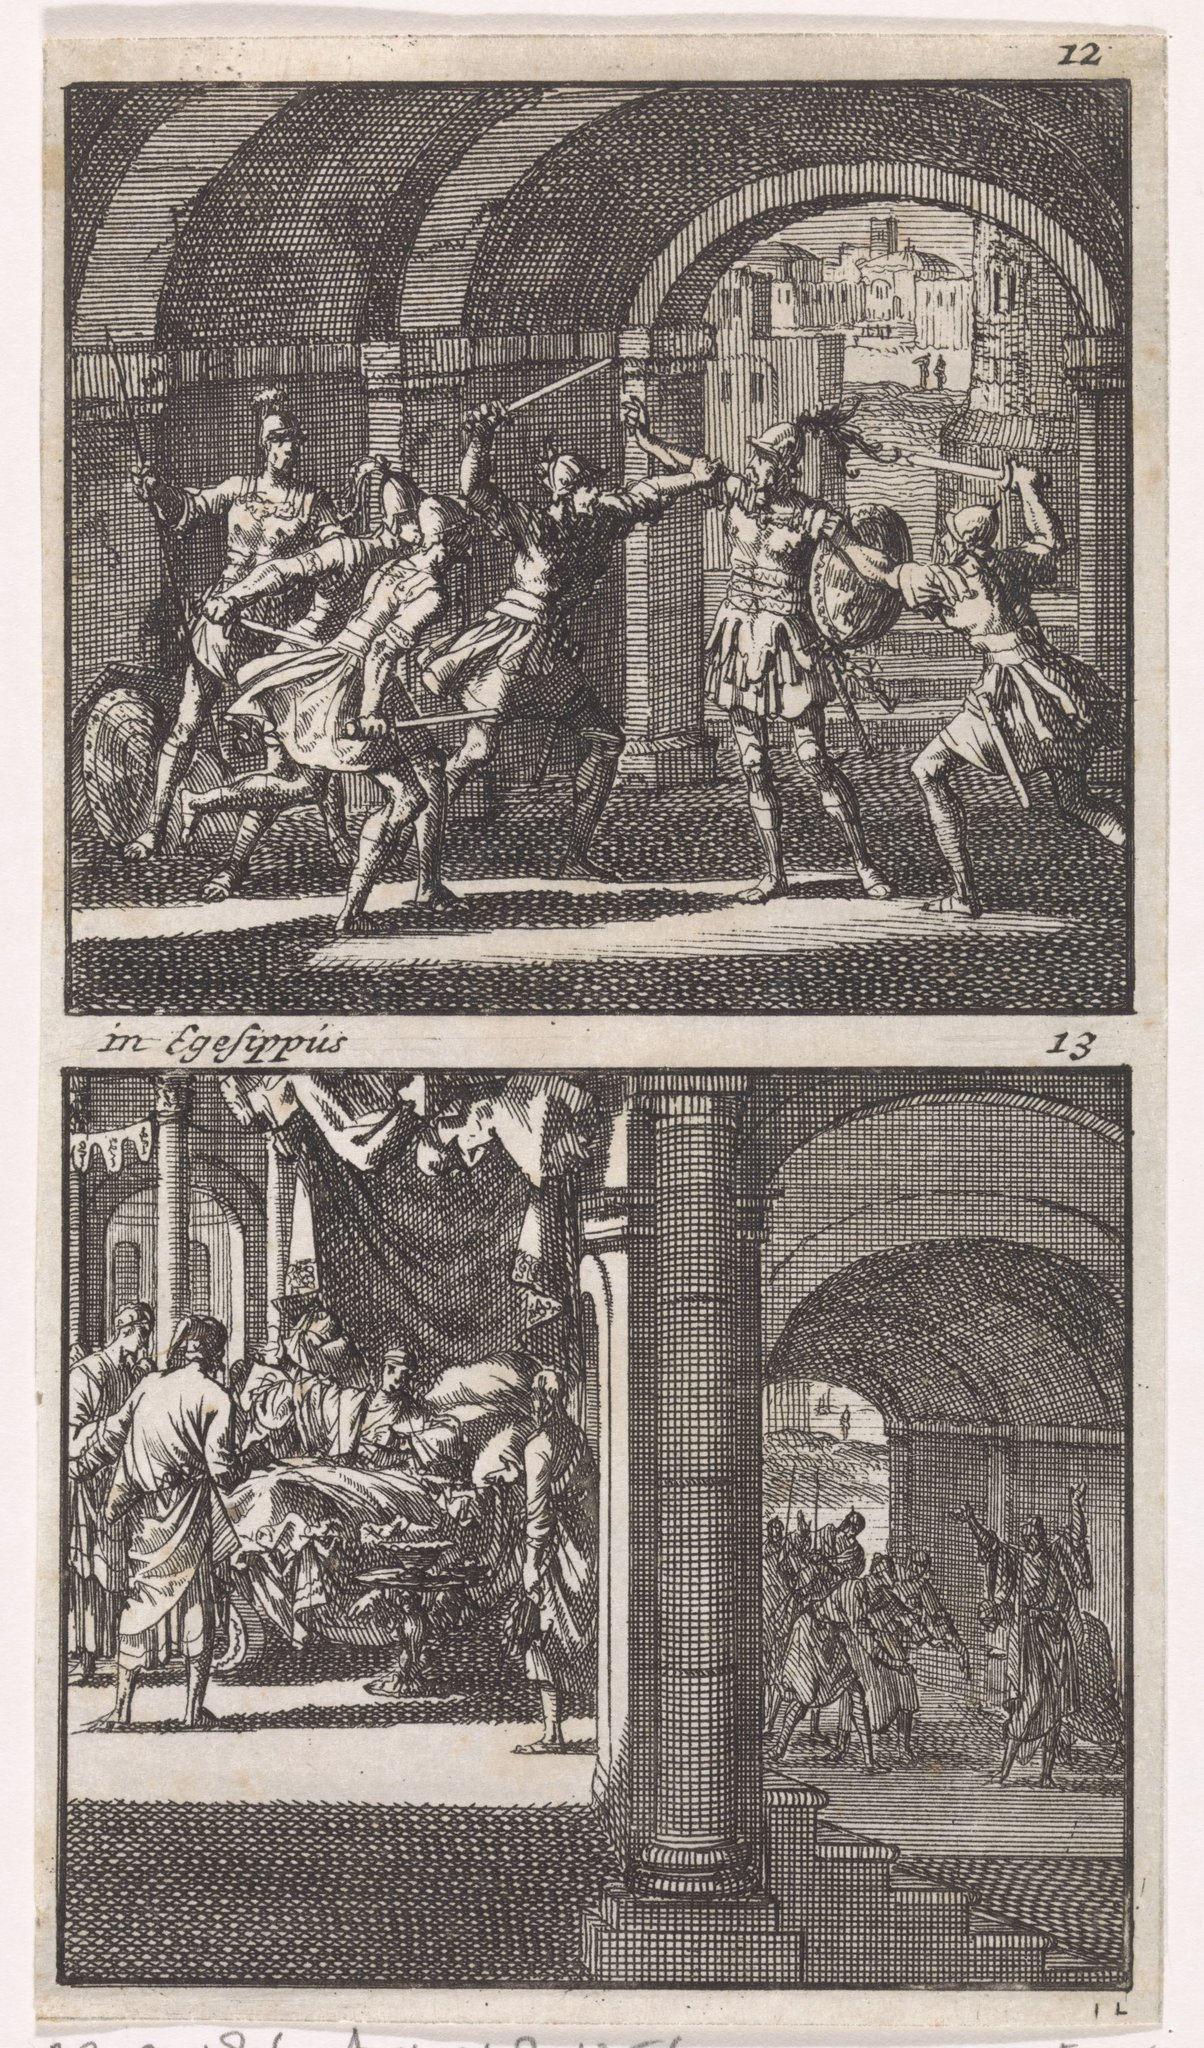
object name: print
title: Antigonus wordt op bevel van zijn broer Aristobulus gedood / Sterfbed van koning Aristobulus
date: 1698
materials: paper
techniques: etching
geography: amsterdam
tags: deathbed, attempt, political murder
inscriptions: collector's mark: Lugt 2228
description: Illustratie uit: Josephus, Flavius. XX. boeken van de oude geschiedenissen der joden, 4 delen. Amsterdam: Barent Visscher, Willem de Coup, Willem van Lamsveld, Andries van Damme, 1698, dl. IV.